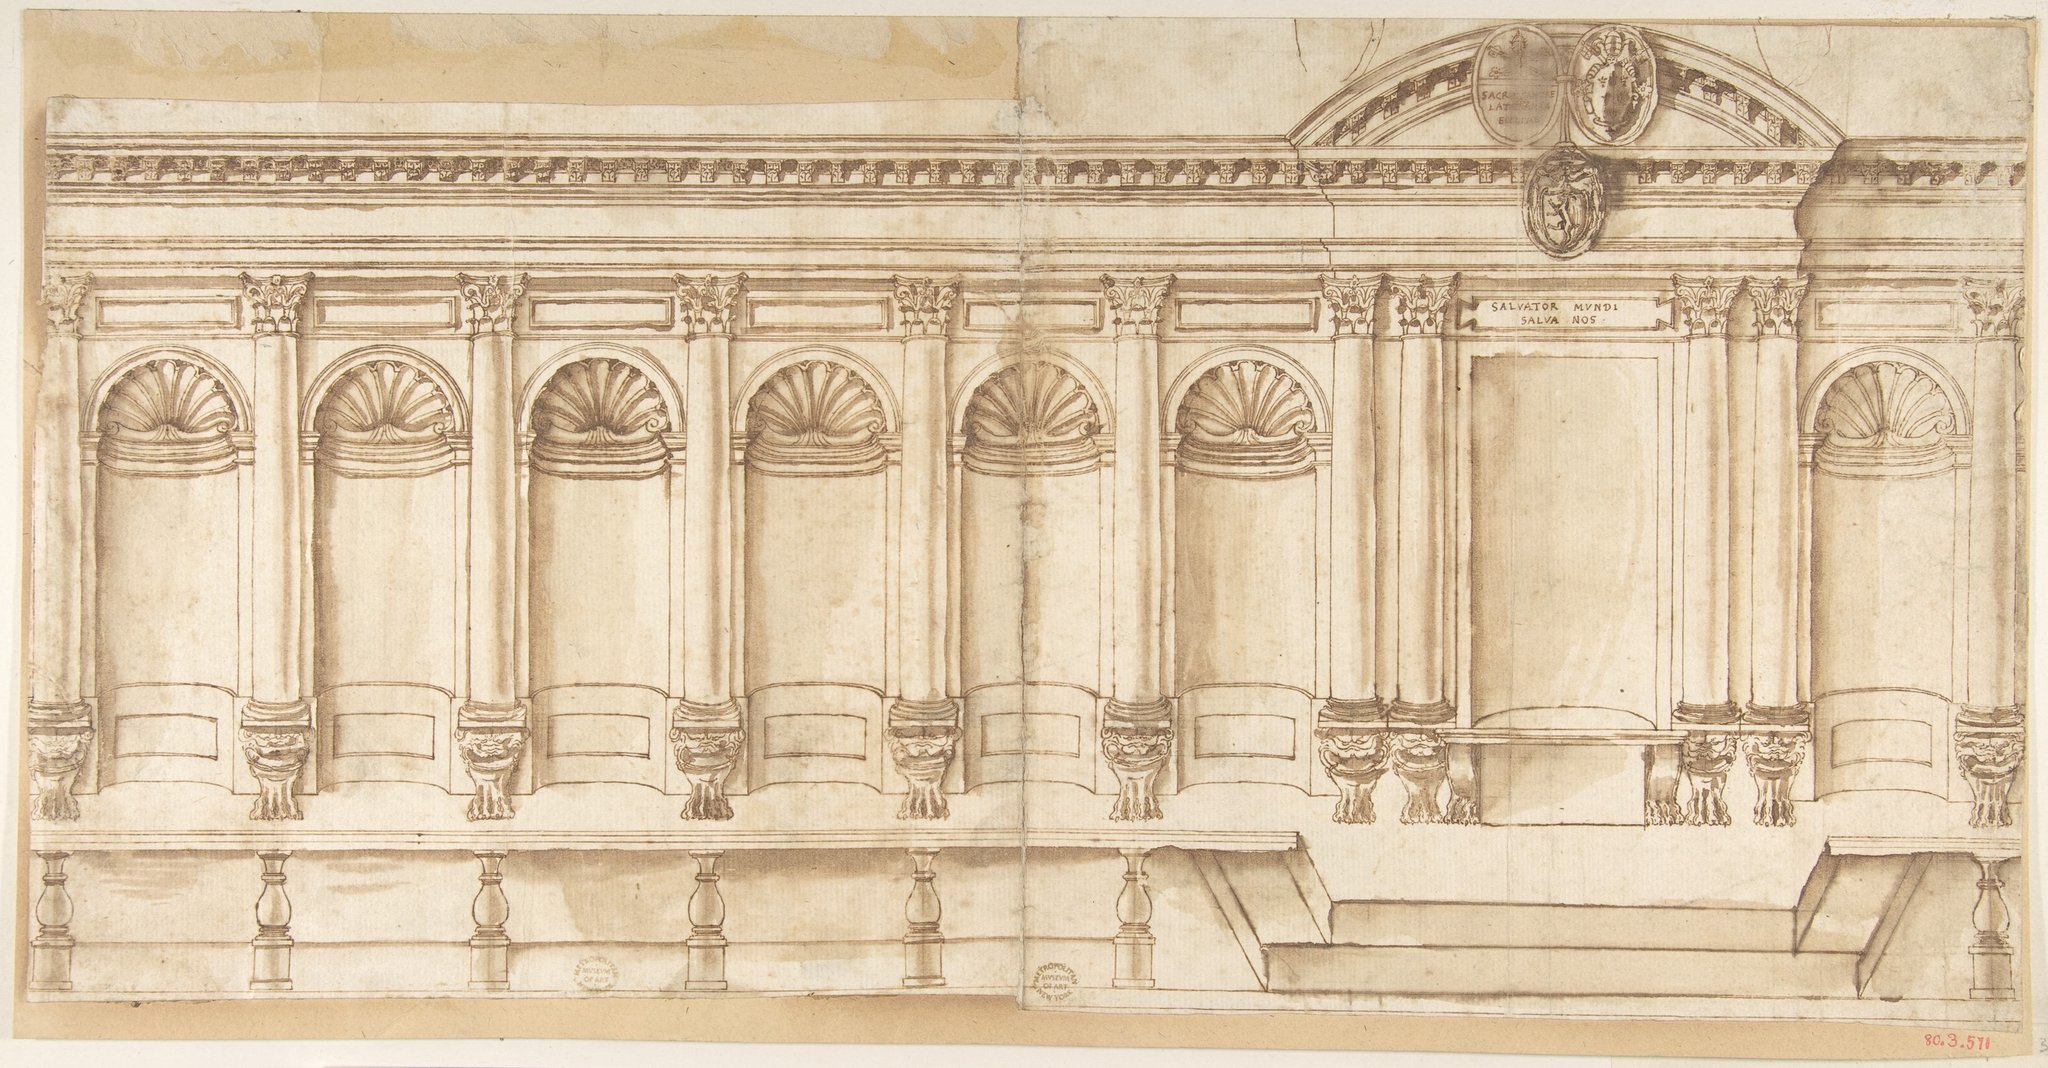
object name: drawing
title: Choir Stalls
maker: anonymous, italian, 16th century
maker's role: artist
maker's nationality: italian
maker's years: 1550-1600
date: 1501-1600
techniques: pen, wash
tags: architecture